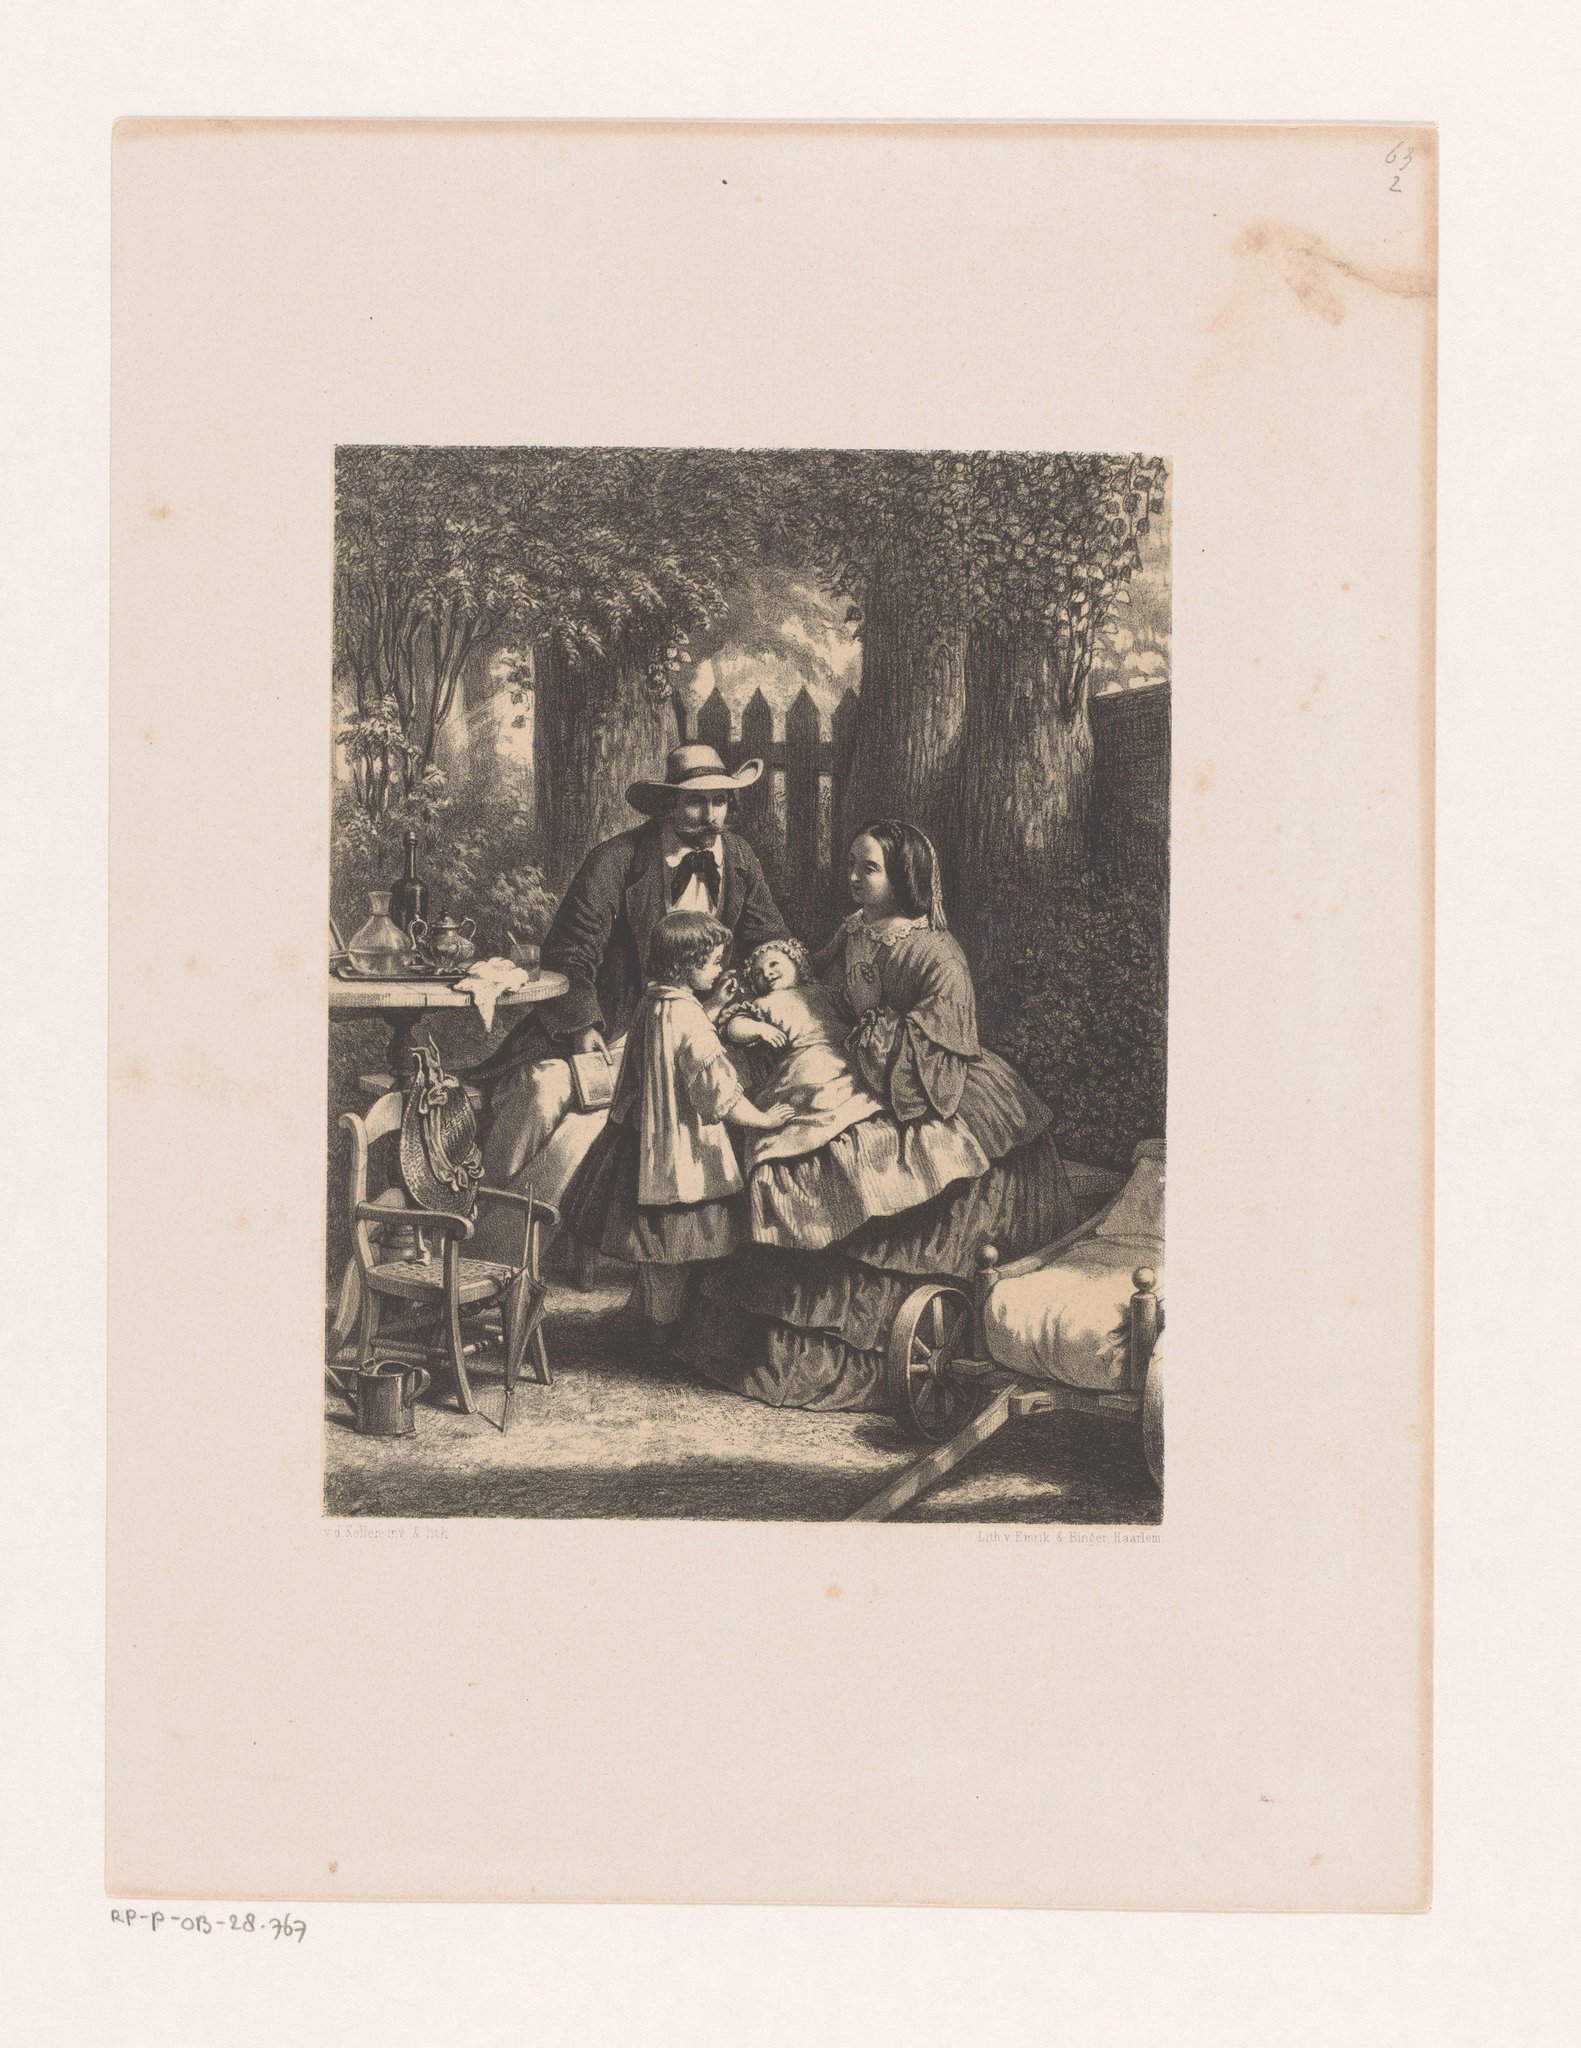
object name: print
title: Gezin in een tuin, mogelijk de familie Van der Kellen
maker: david van der kellen (1827-1895)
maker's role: draughtsman, print maker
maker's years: 1827-1895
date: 1837-1895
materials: paper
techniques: tone lithography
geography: haarlem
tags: baby-carriage, pram, perambulator, family group, especially parents with their child(ren), garden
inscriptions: collector's mark: Lugt 2228, inscription: ‘D. v. d. Kellen en vrouw A. W. van der Kellen / en kinderen A. C. v. d. Kellen en H. F. v. d. Kellen. / Woning weteringschans bij melkinrichting (...)’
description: De vrouw heeft een baby op schoot. Bij hen staat een kleuter. Achter hen zit de vader met een boek in zijn hand. Links een tafel en een stoel, rechts een kinderwagen.